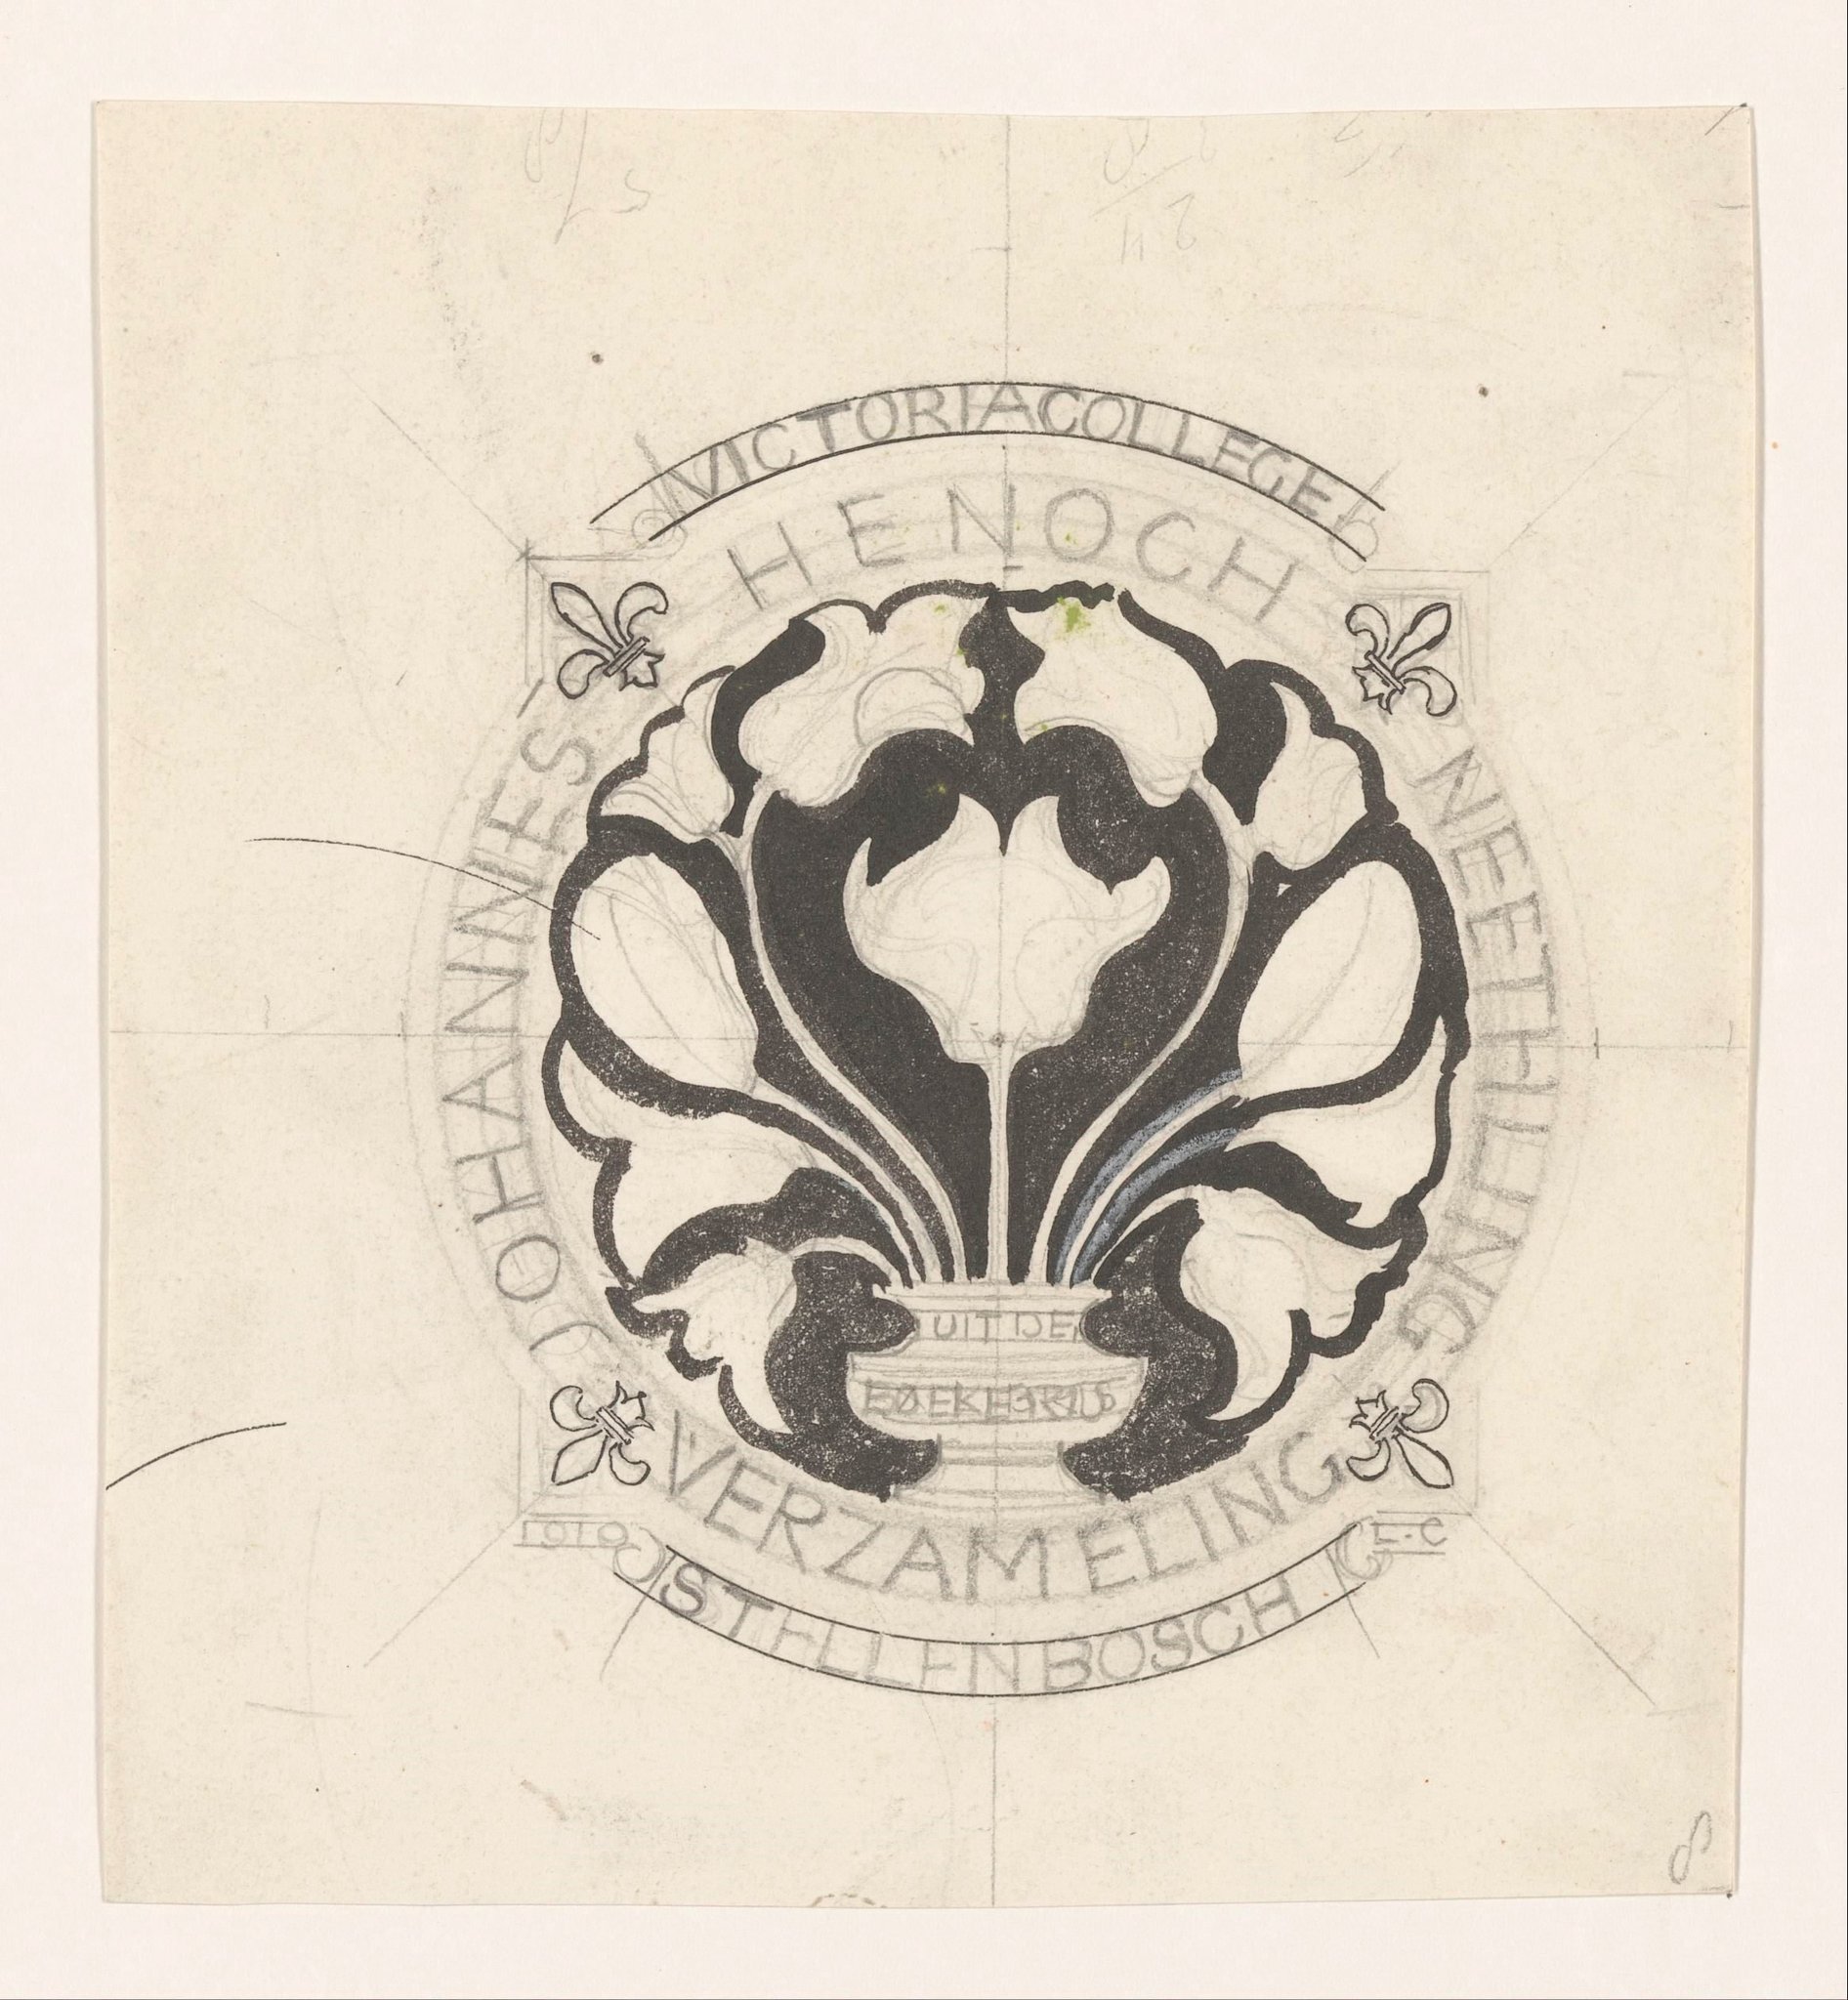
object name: design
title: Ontwerp voor een ex libris van Johannes Henoch Neethling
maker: carel adolph lion cachet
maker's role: draughtsman, print maker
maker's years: 1864-1945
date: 1874-1945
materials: paper, pencil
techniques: brush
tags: ex-libris, flowers ~ ornament